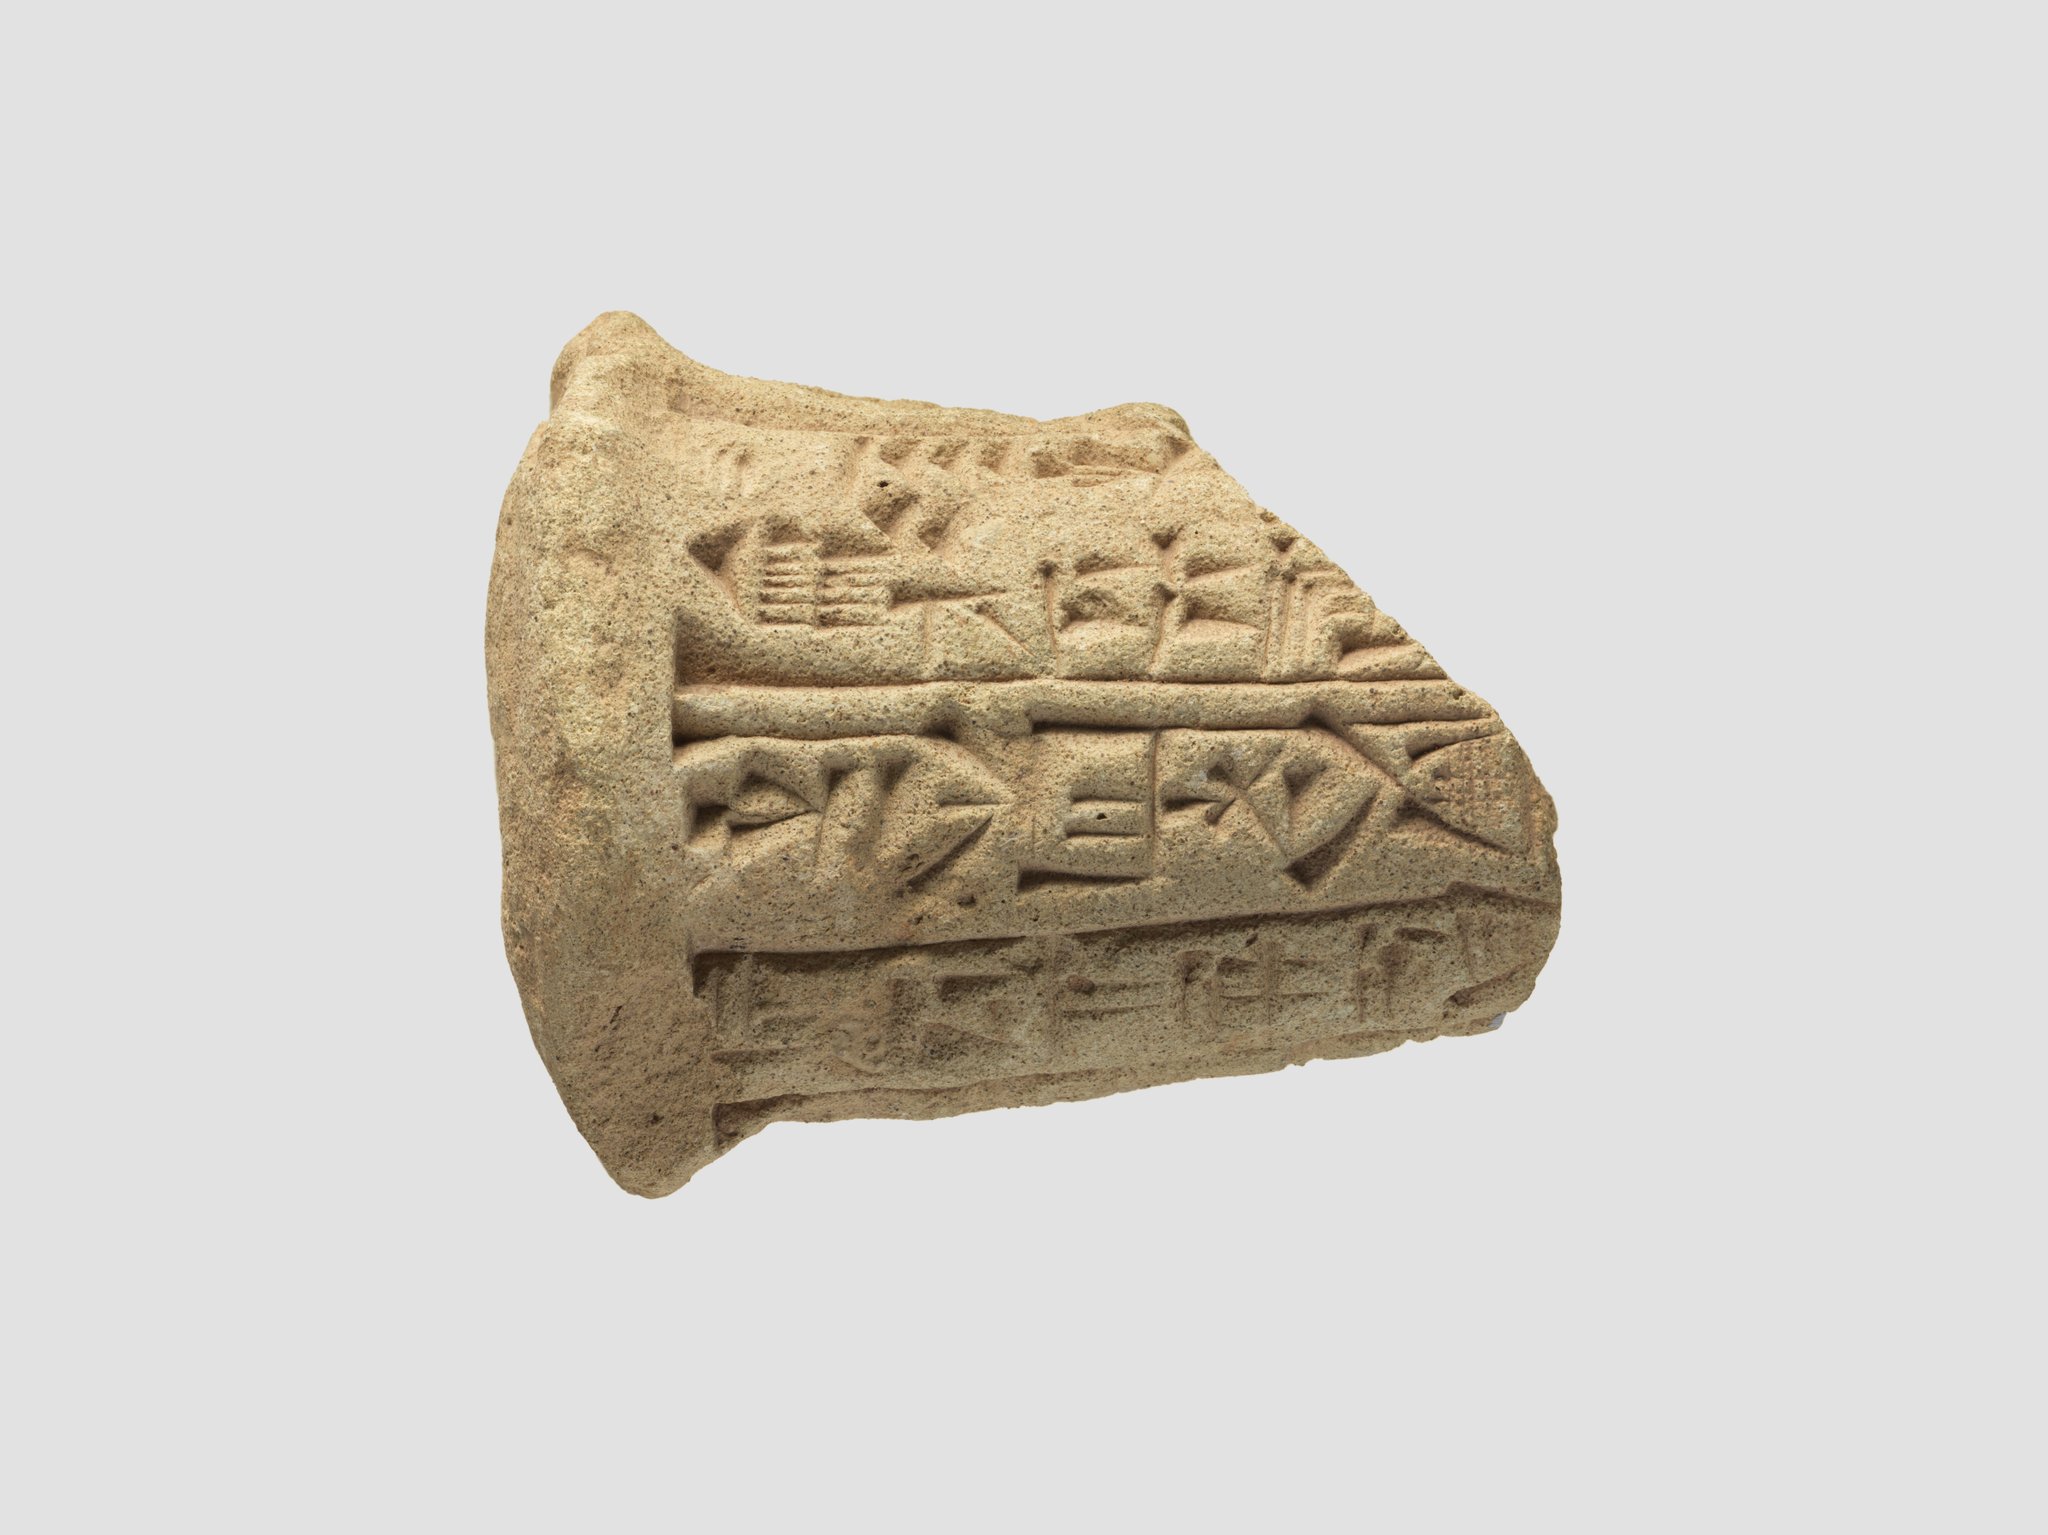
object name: cuneiform cone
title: Votive cone with cuneiform inscription of Gudea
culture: neo-sumerian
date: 2090 BCE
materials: clay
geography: mesopotamia